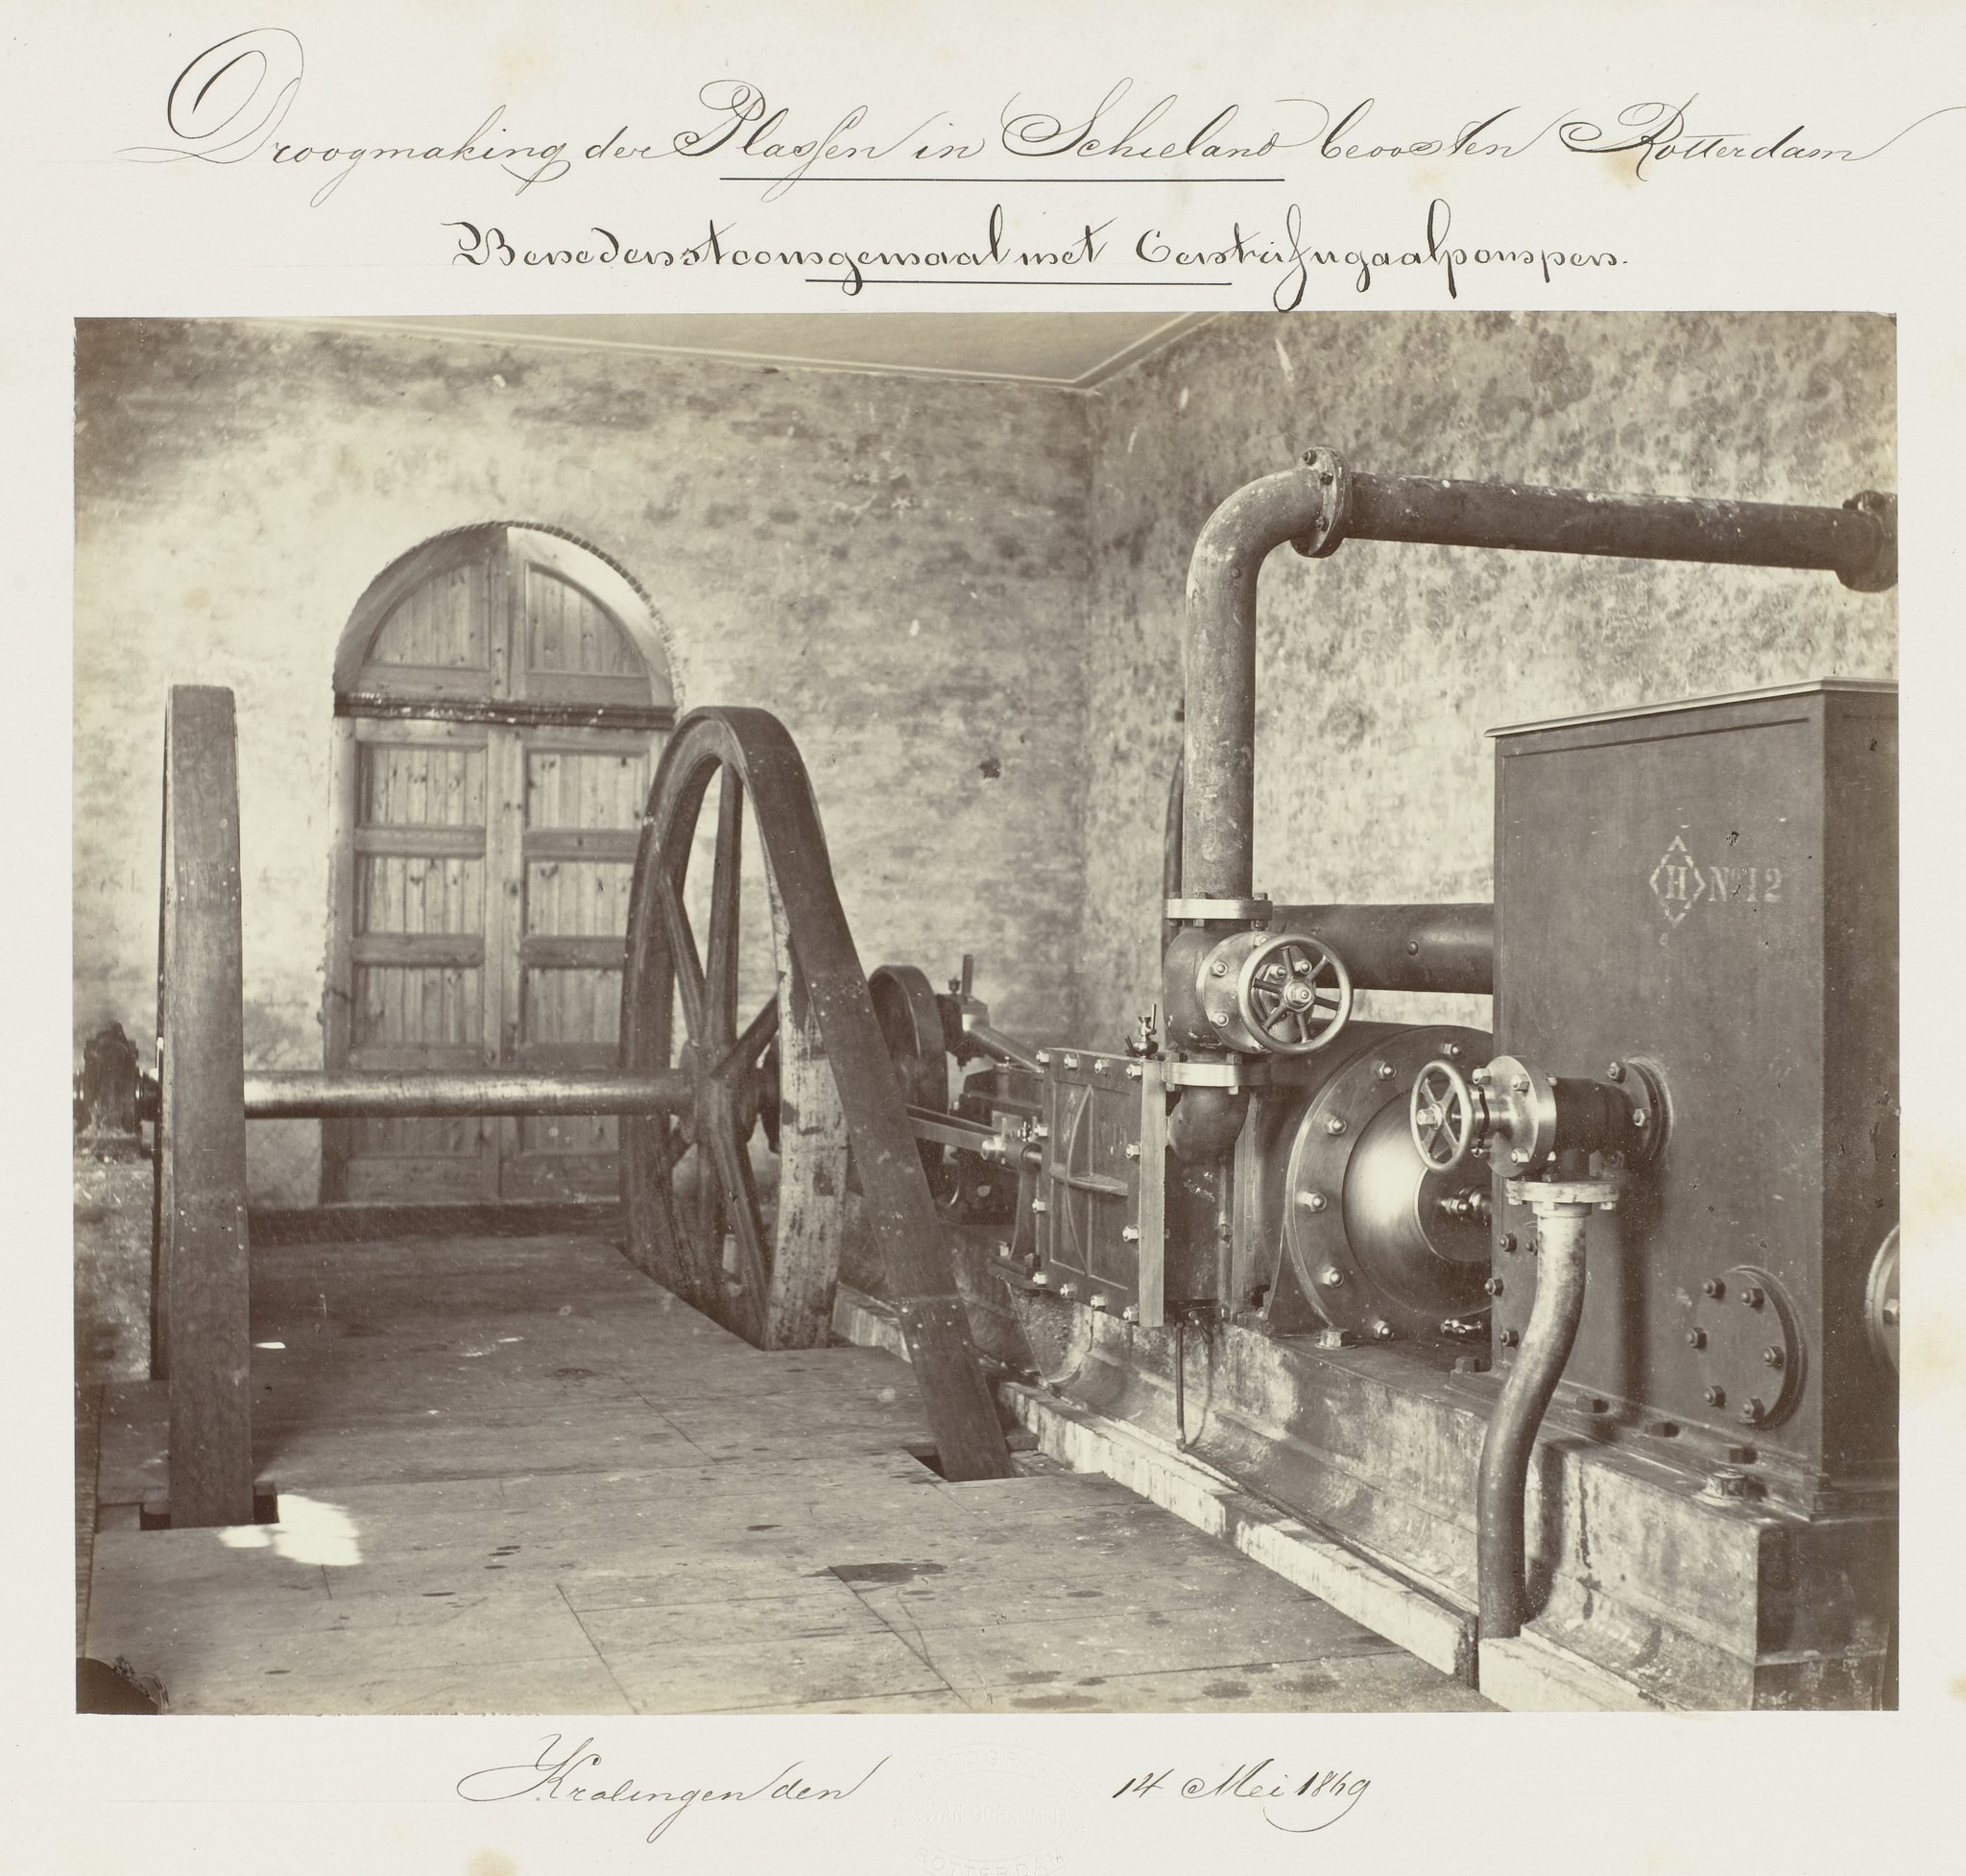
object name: photograph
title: Droogmaking der Plassen in Schieland, beoosten Rotterdam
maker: jacobus van gorkom (jr.)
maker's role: print maker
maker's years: 1827-1880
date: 1868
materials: cardboard, paper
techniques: photography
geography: rotterdam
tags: rotterdam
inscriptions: date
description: Foto op karton van een droogmaking (plassen bij Rotterdam); gedateerd, met opschrift in pen: Nieuwerkerk a/d IJssel.